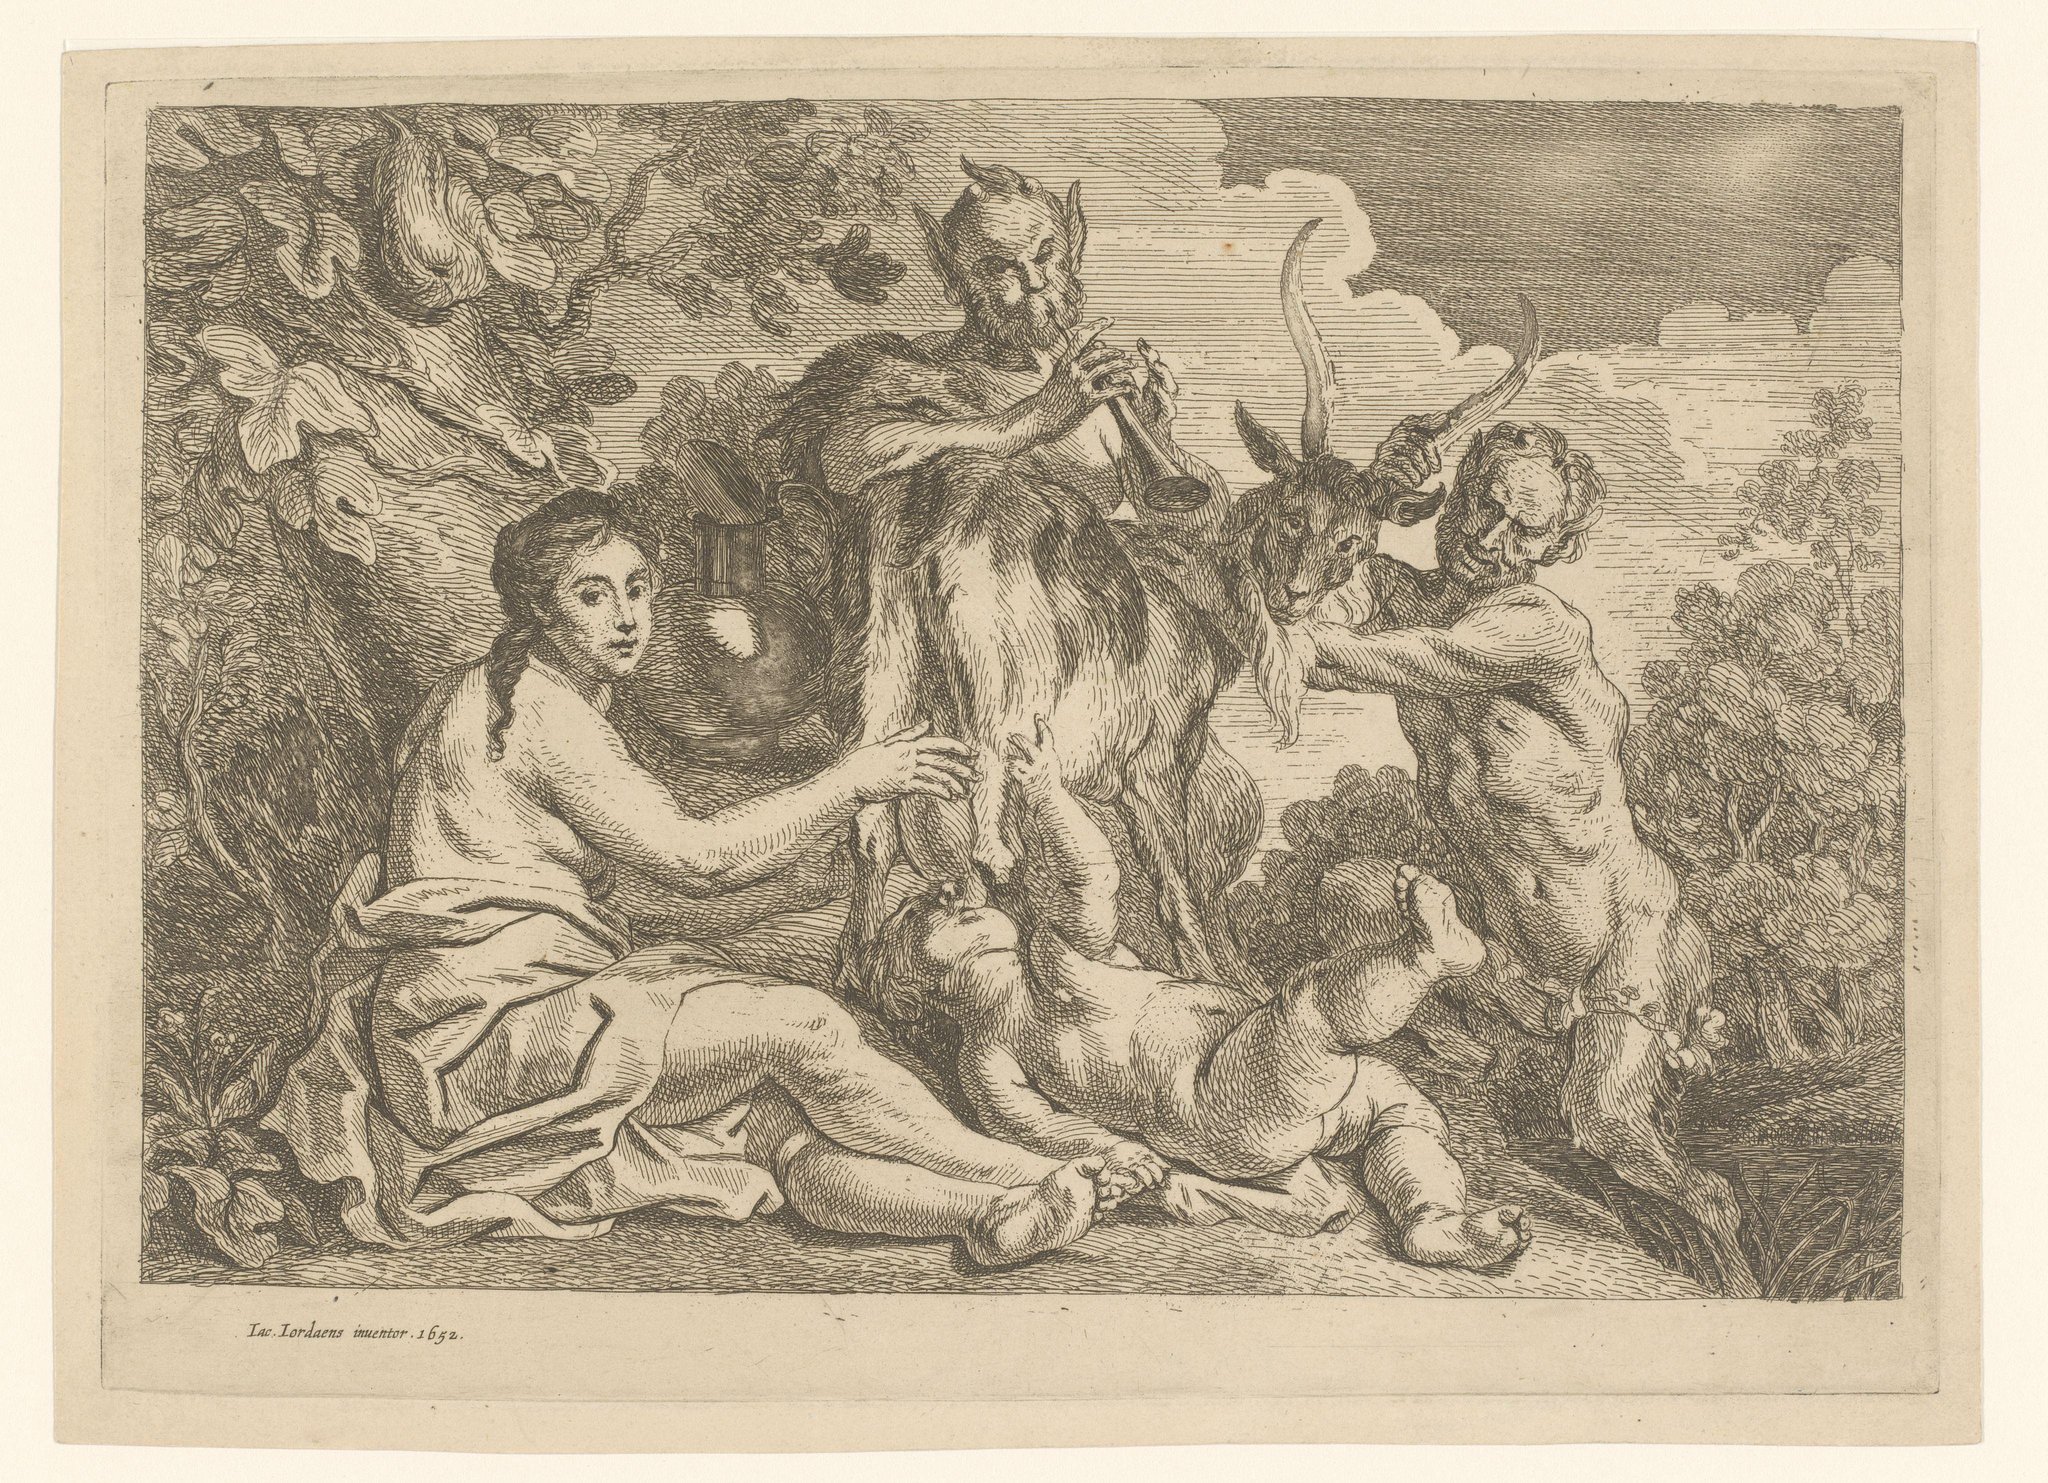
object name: print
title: Jupiter wordt gevoed door de geit Amalthea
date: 1652-1690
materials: paper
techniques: etching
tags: amalthea, the nymph, usually in the shape of a goat, suckles the new-born jupiter, goat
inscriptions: collector's mark: Lugt 2228